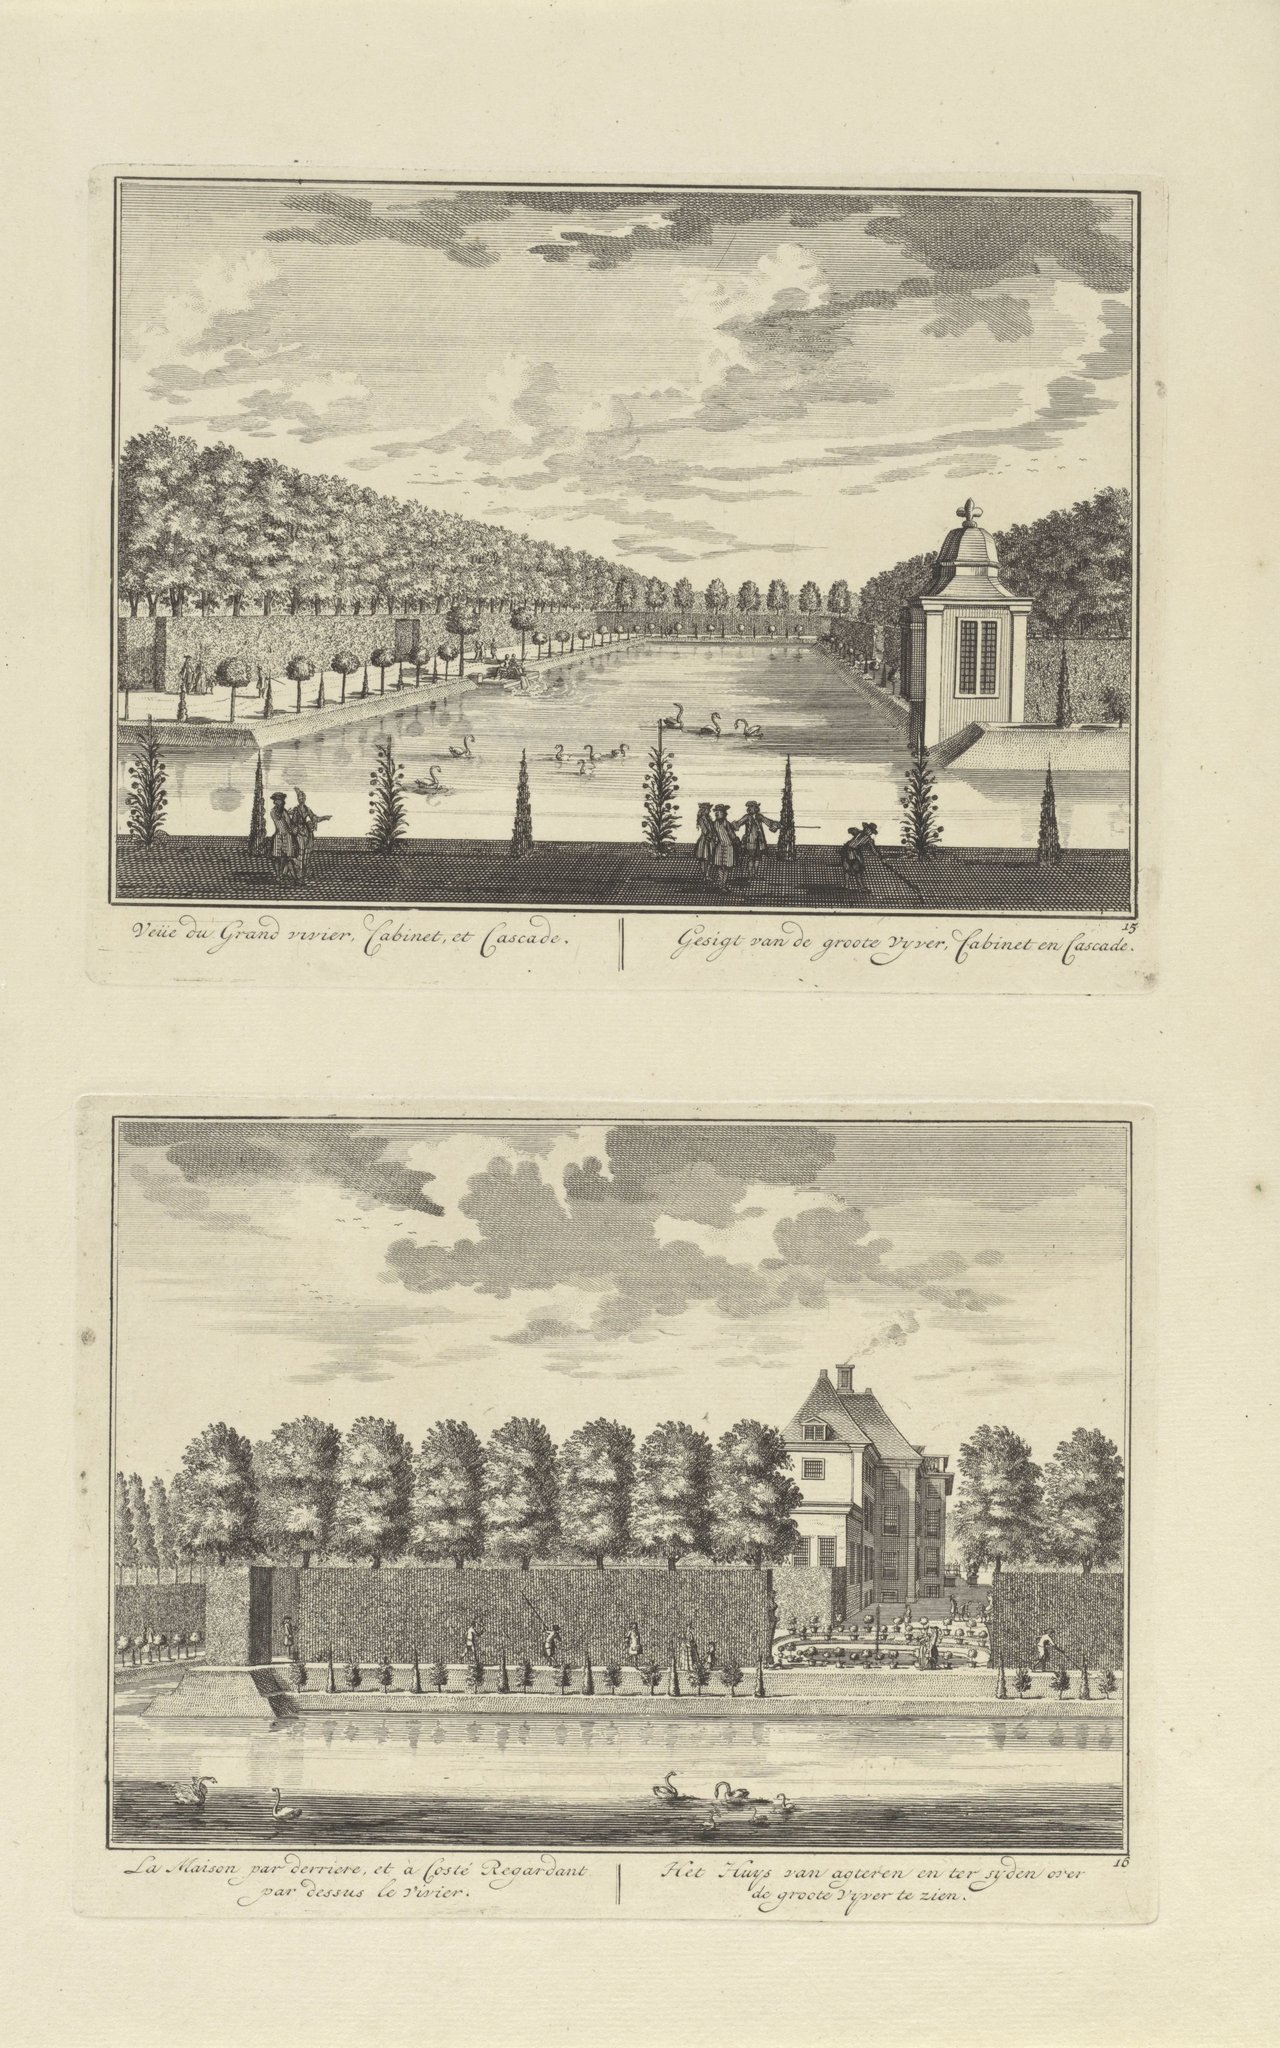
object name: print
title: Gesigt van de groote vyver, Cabinet en Cascade / Veüe du Grand vivier, Cabinet et Cascade / Het Huys van agteren en ter syden over de groote vyver te zien / La Maison par derriere, et a Costé Regardent par dessus le vivier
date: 1682-1726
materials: paper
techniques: etching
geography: amsterdam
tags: garden buildings, garden pond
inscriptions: collector's mark: Lugt 2228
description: Twee voorstellingen op een blad. Boven: Gezicht op de grote vijver ten noordwesten van Slot Zeist met het noordwestelijke tuinpaviljoen, uit het zuidwesten. Onder: Gezicht over de grote vijver ten noordwesten van Slot Zeist op de zij- en de achtergevel van het huis, uit het noordwesten.